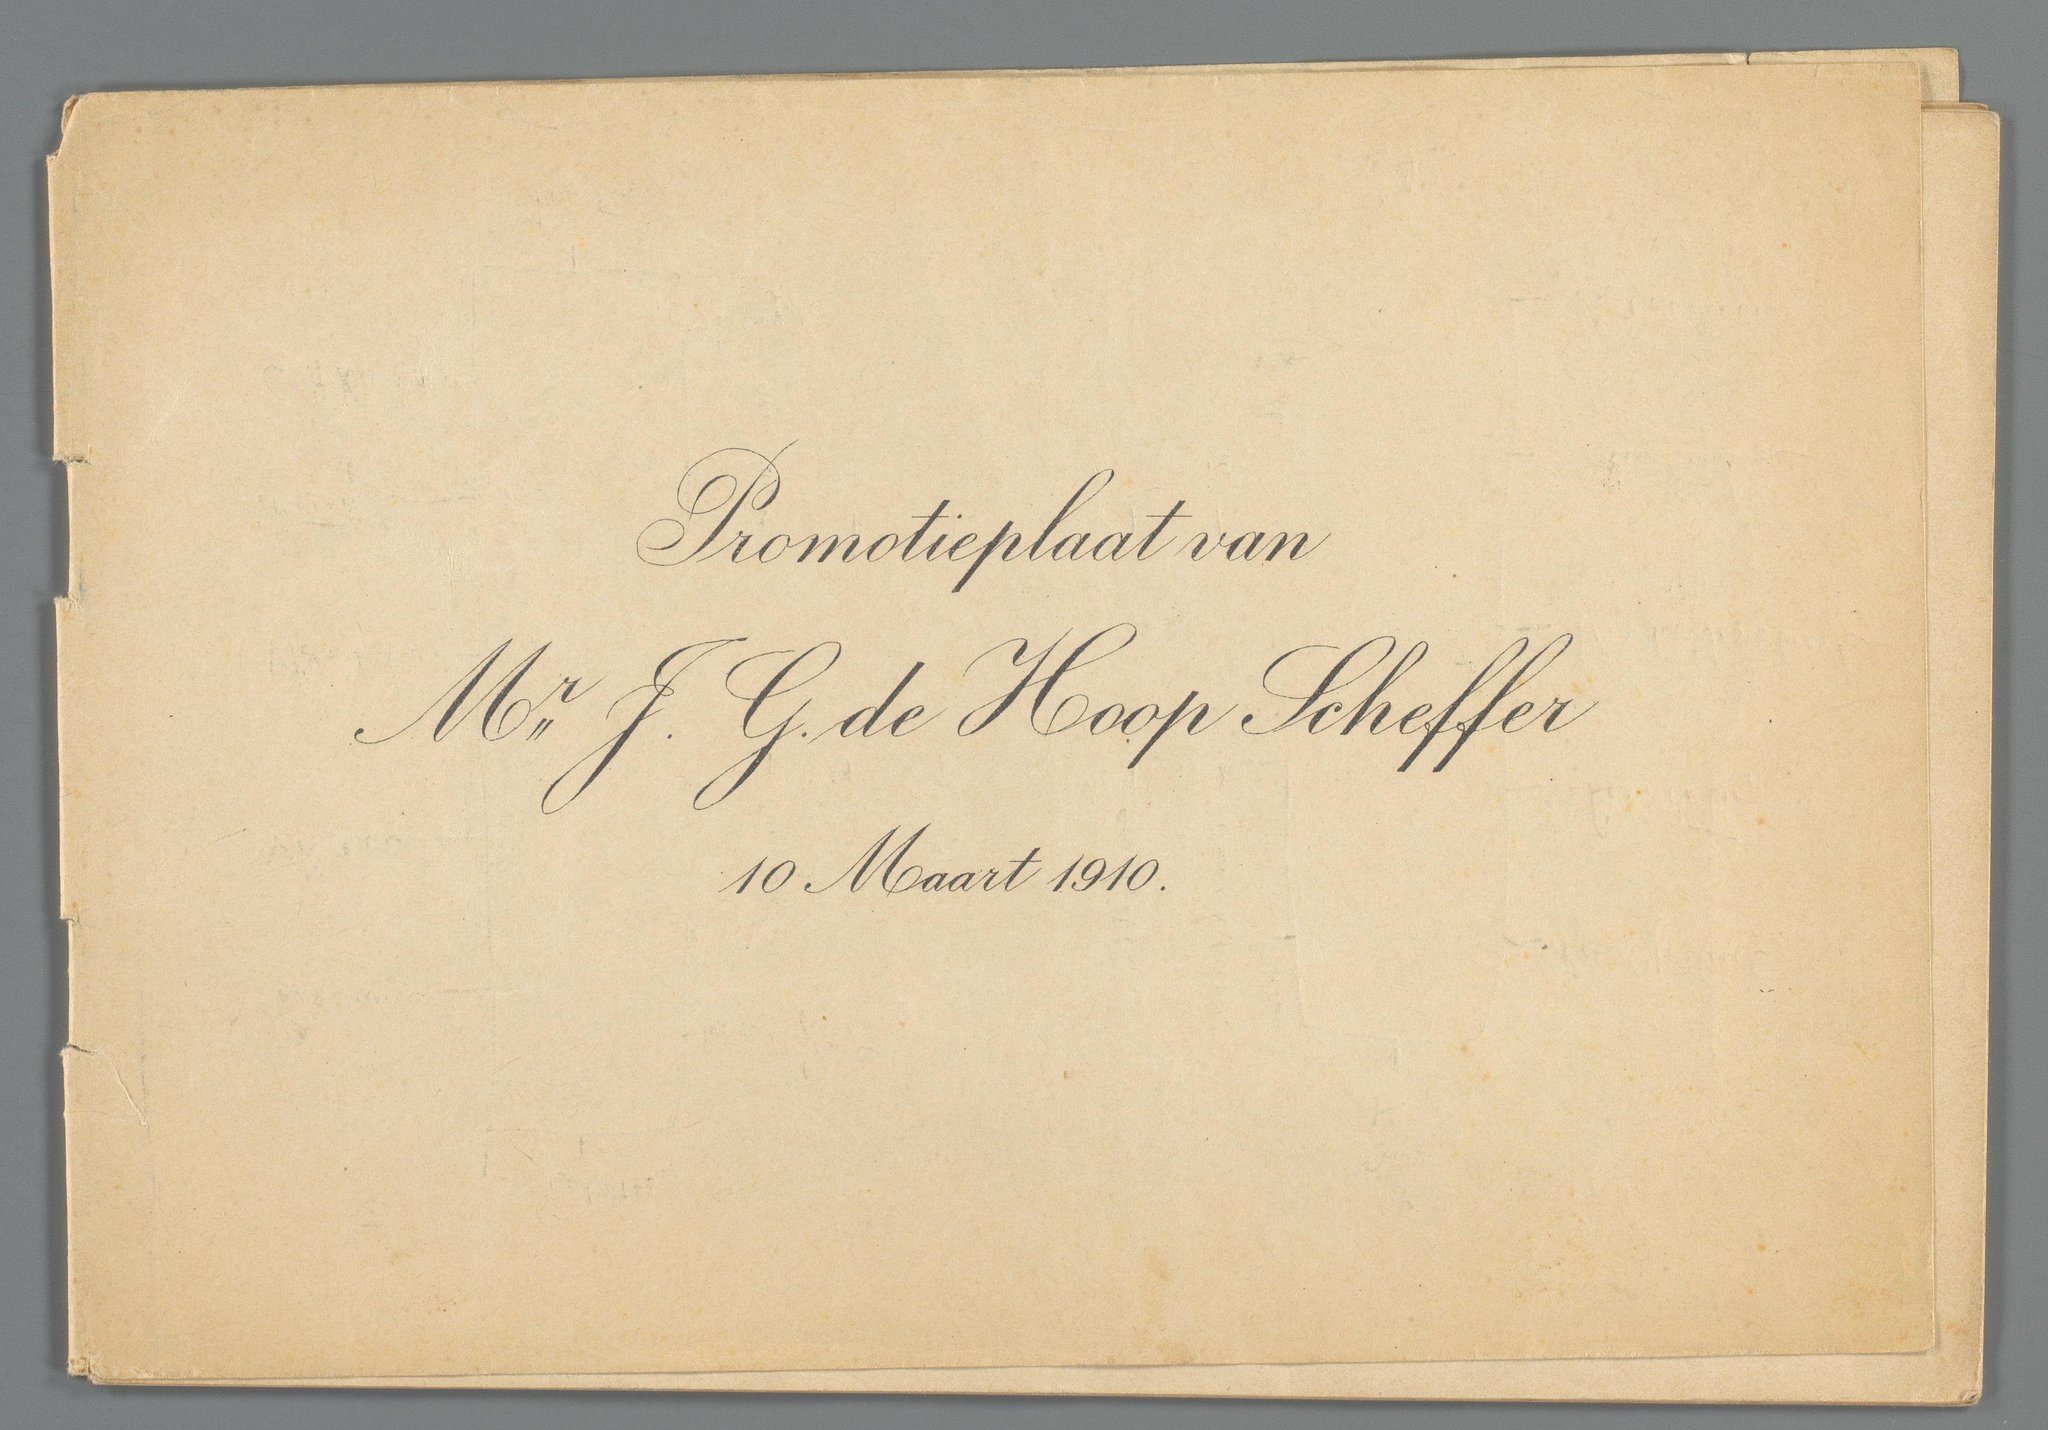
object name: album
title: Album bij de promotie van Mr. J.G. de Hoop Scheffer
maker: Anonymous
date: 1910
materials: paper, pencil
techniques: letterpress printing, lithograph, stapling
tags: amsterdam, receiving doctor's degree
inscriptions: date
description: Album met negen prenten, acht gedichten, en op de achterzijde handtekeningen van aanwezigen en genodigden. Op de binnenzijde van het omslag is in potlood een tafelschikking getekend.